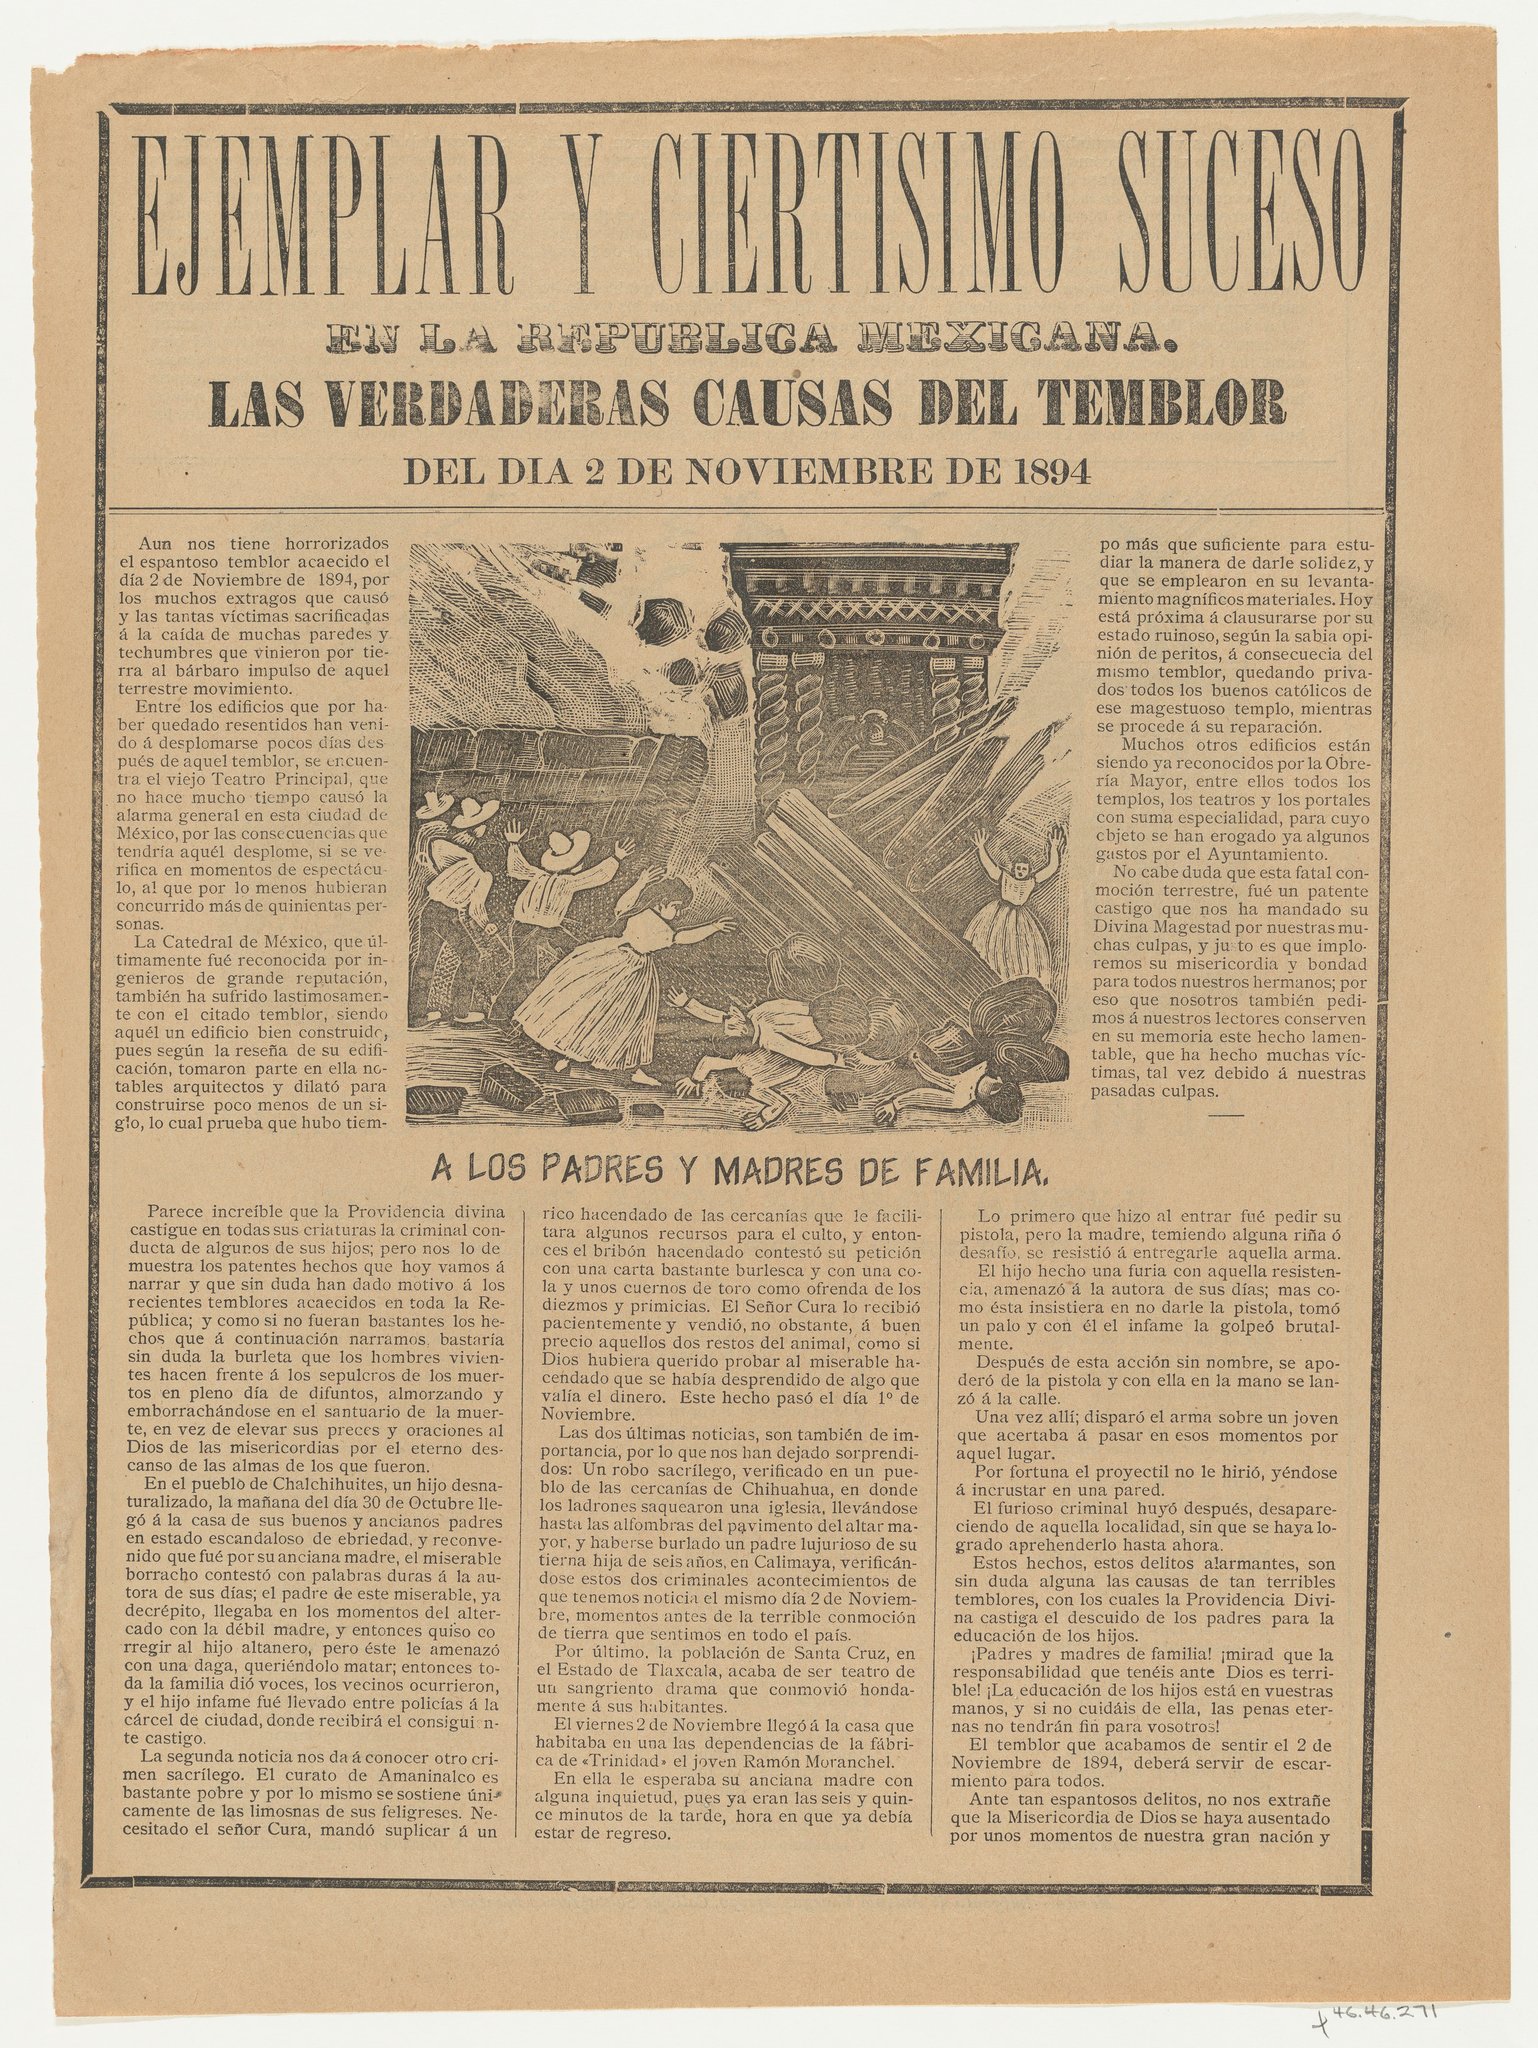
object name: print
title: Broadsheet relating to the causes of the earthquake on 2 November 1894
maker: Anonymous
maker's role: artist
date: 1894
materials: paper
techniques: letterpress